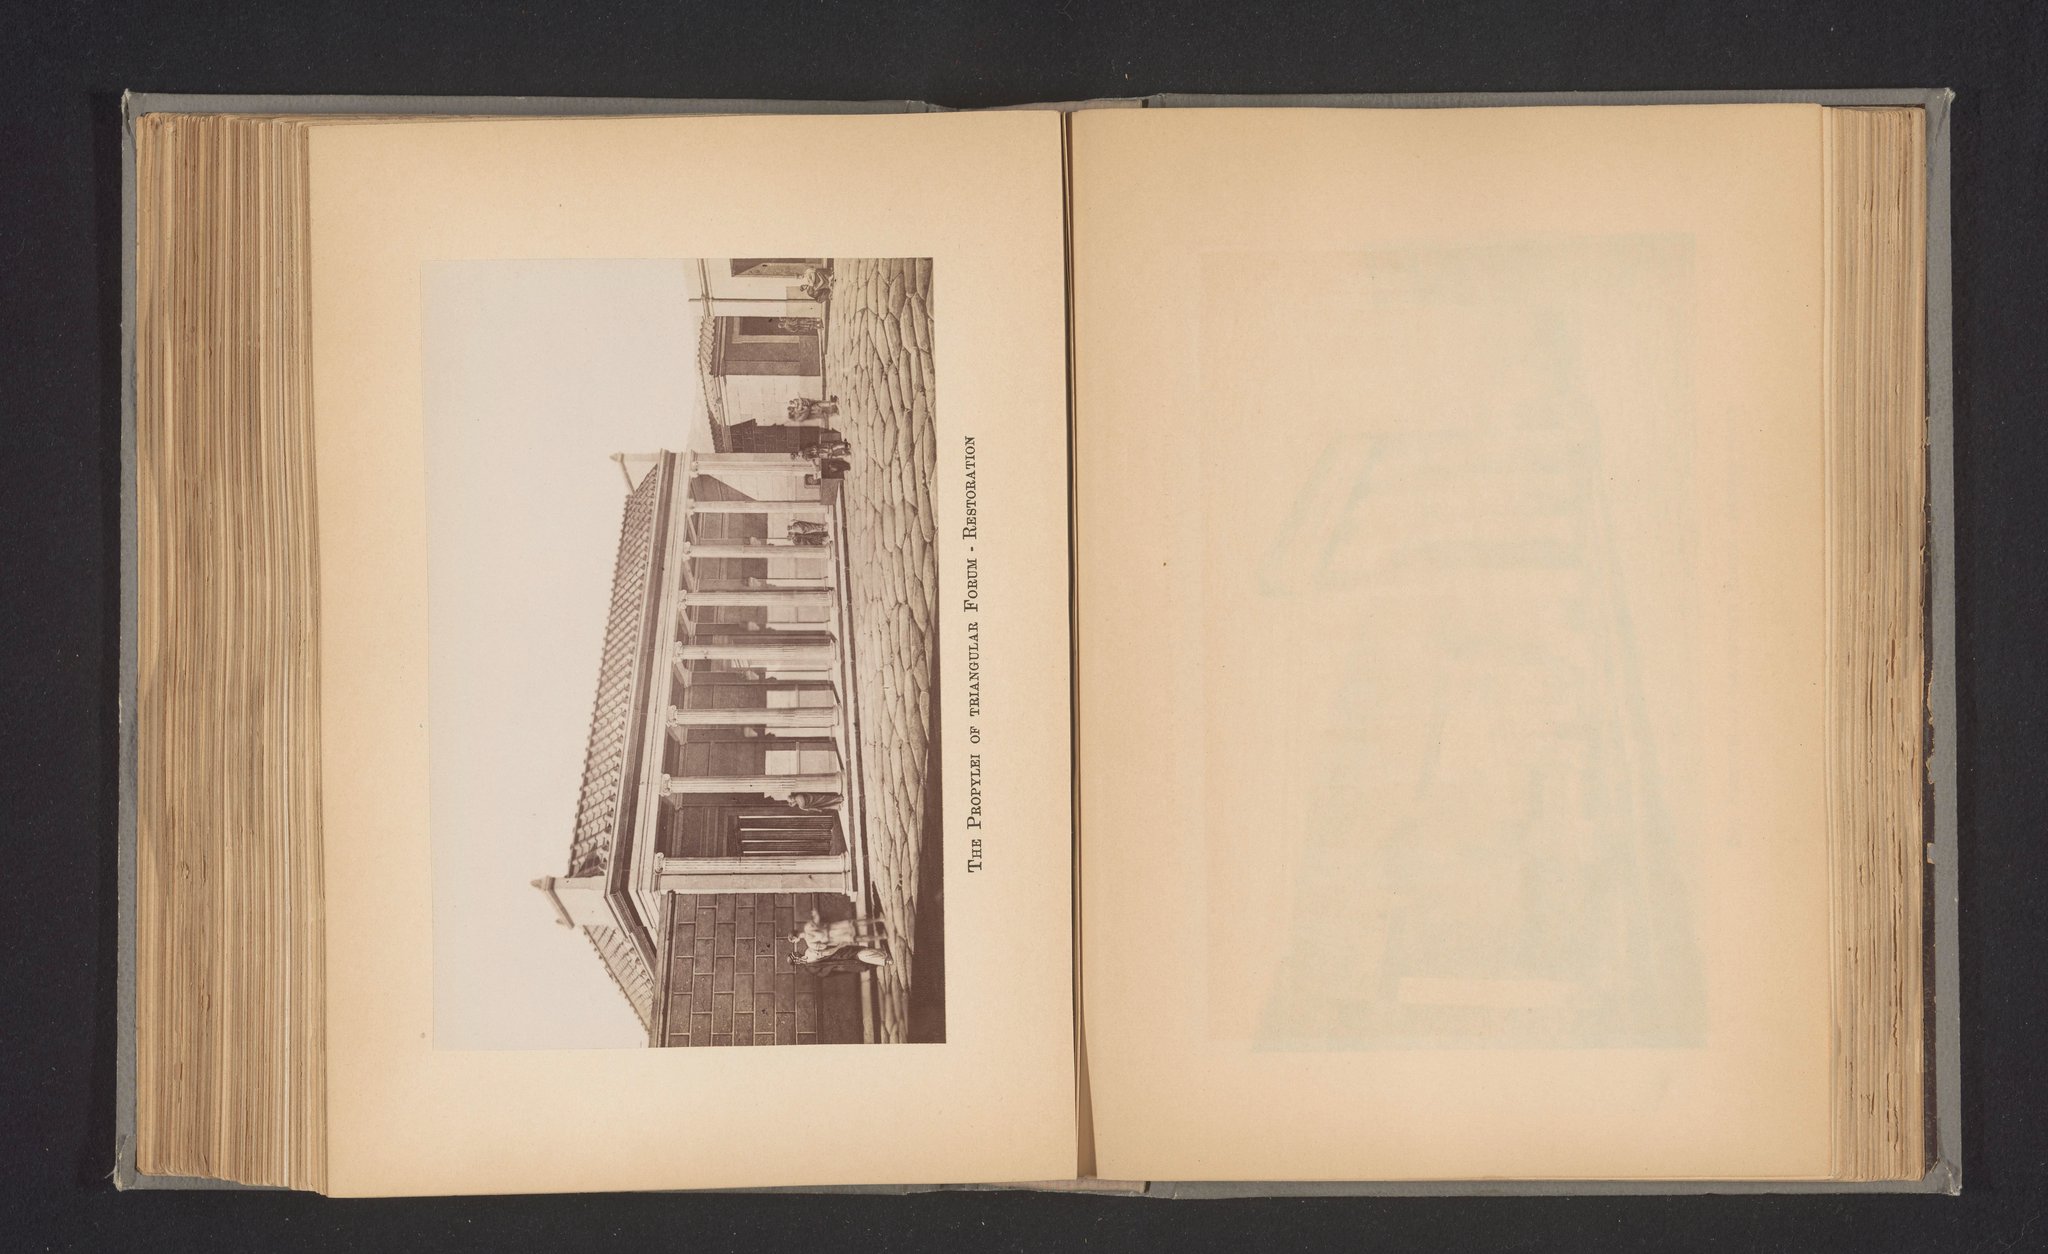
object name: photograph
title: Fotoreproductie van een gezicht op het driehoekig Forum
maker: Anonymous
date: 1890-1895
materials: photographic support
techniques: albumen print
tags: civic architecture; edifices; dwellings, pompeii